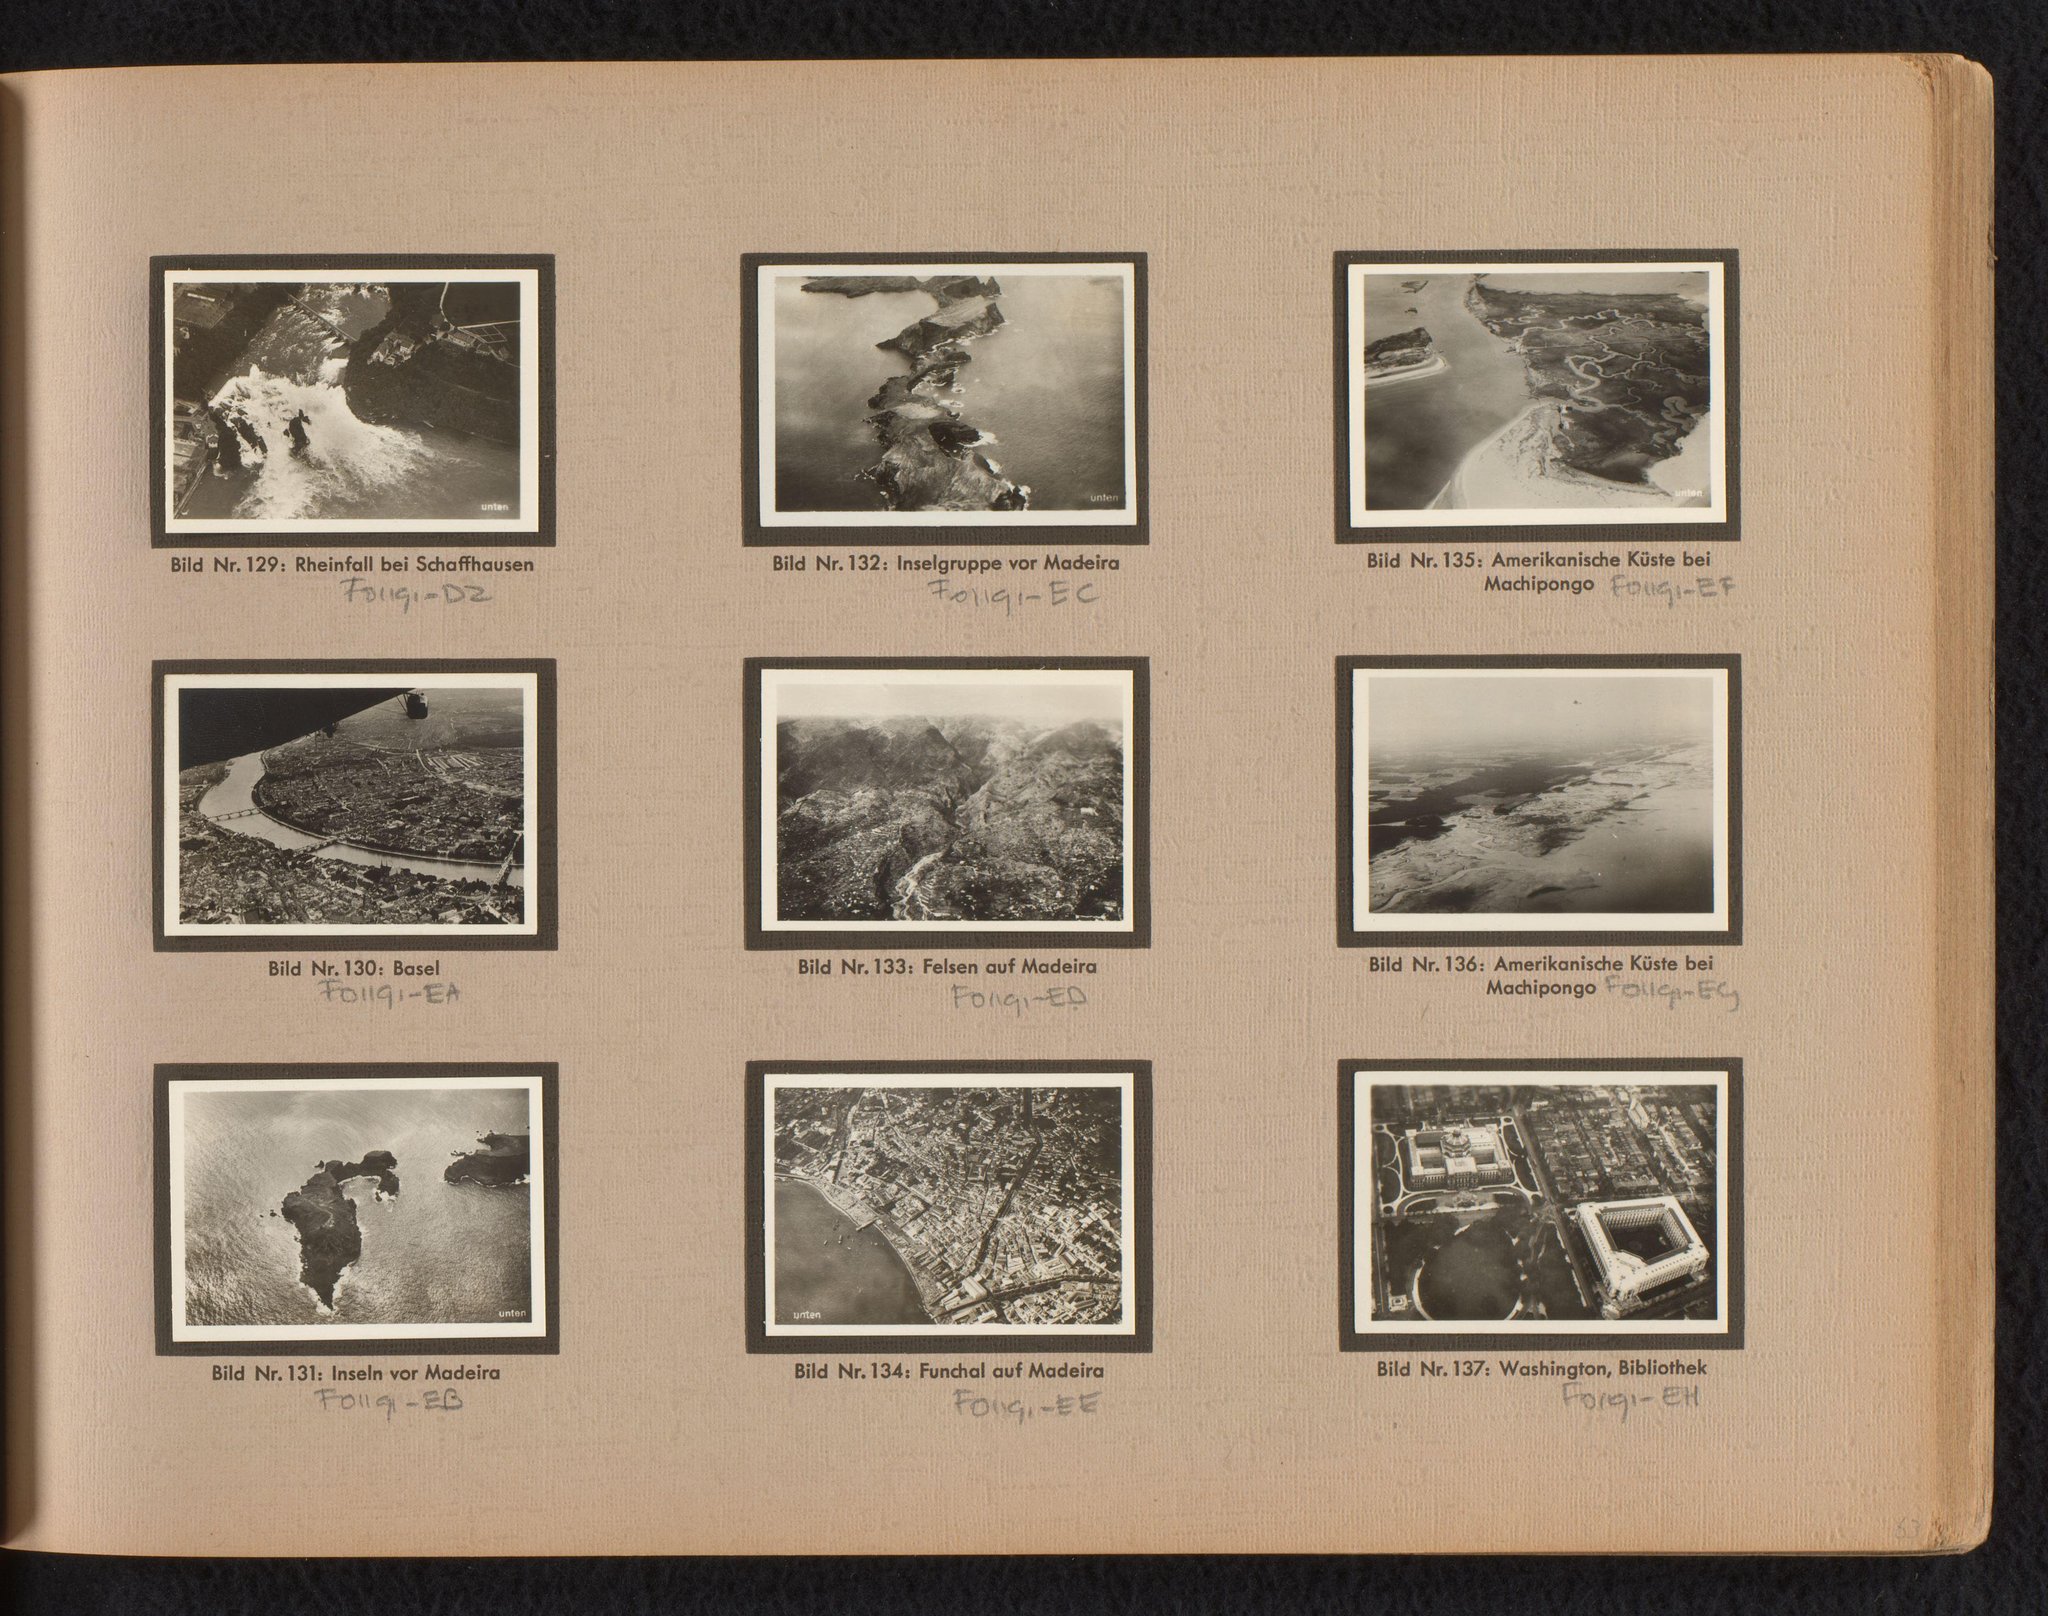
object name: photograph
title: Uitzichten tijdens een vlucht naar de Verenigde Staten van Amerika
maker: Anonymous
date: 1924-1928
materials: paper, photographic support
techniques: gelatin silver print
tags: city-view, and landscape with man-made constructions, island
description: Negen foto's gemaakt tijdens vluchten naar Verenigde Staten van Amerika, waaronder gezichten op Schaffhausen, Madeira, Basel, Machipongo en Washington. Alle foto's zijn voorzien van een nummer en titel. Deze pagina maakt deel uit van een album.